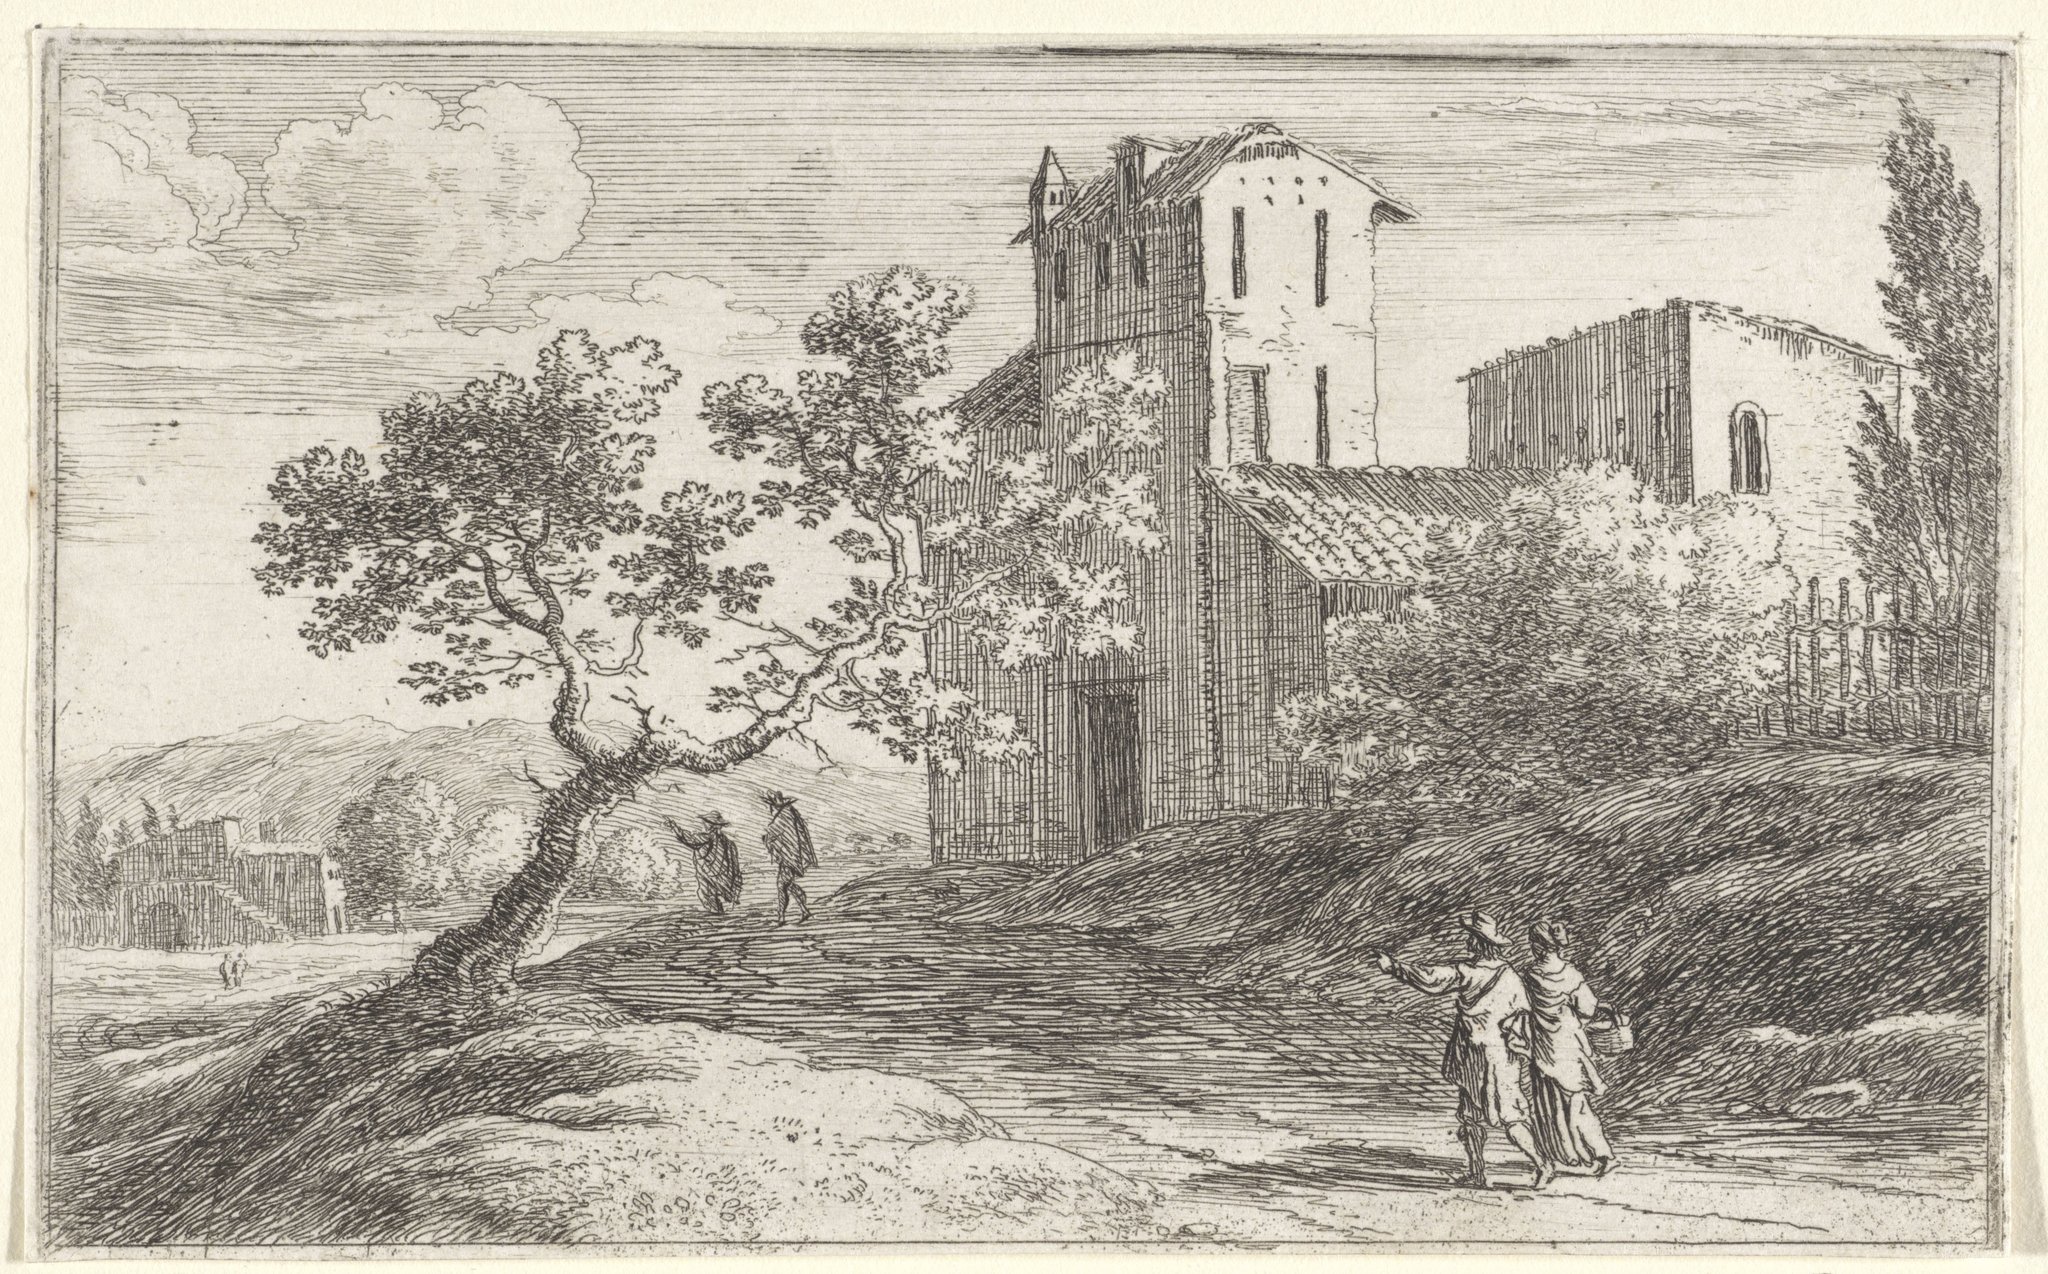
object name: print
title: Titelblad en twaalf gezichten op Rome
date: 1629-1655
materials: paper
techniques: etching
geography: rome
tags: landscapes, roman catholic church, rome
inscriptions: collector's mark: Lugt 240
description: Tussen een gebogen kromme boom en een gebouw met een toren loopt een pad met enkele wandelaars.